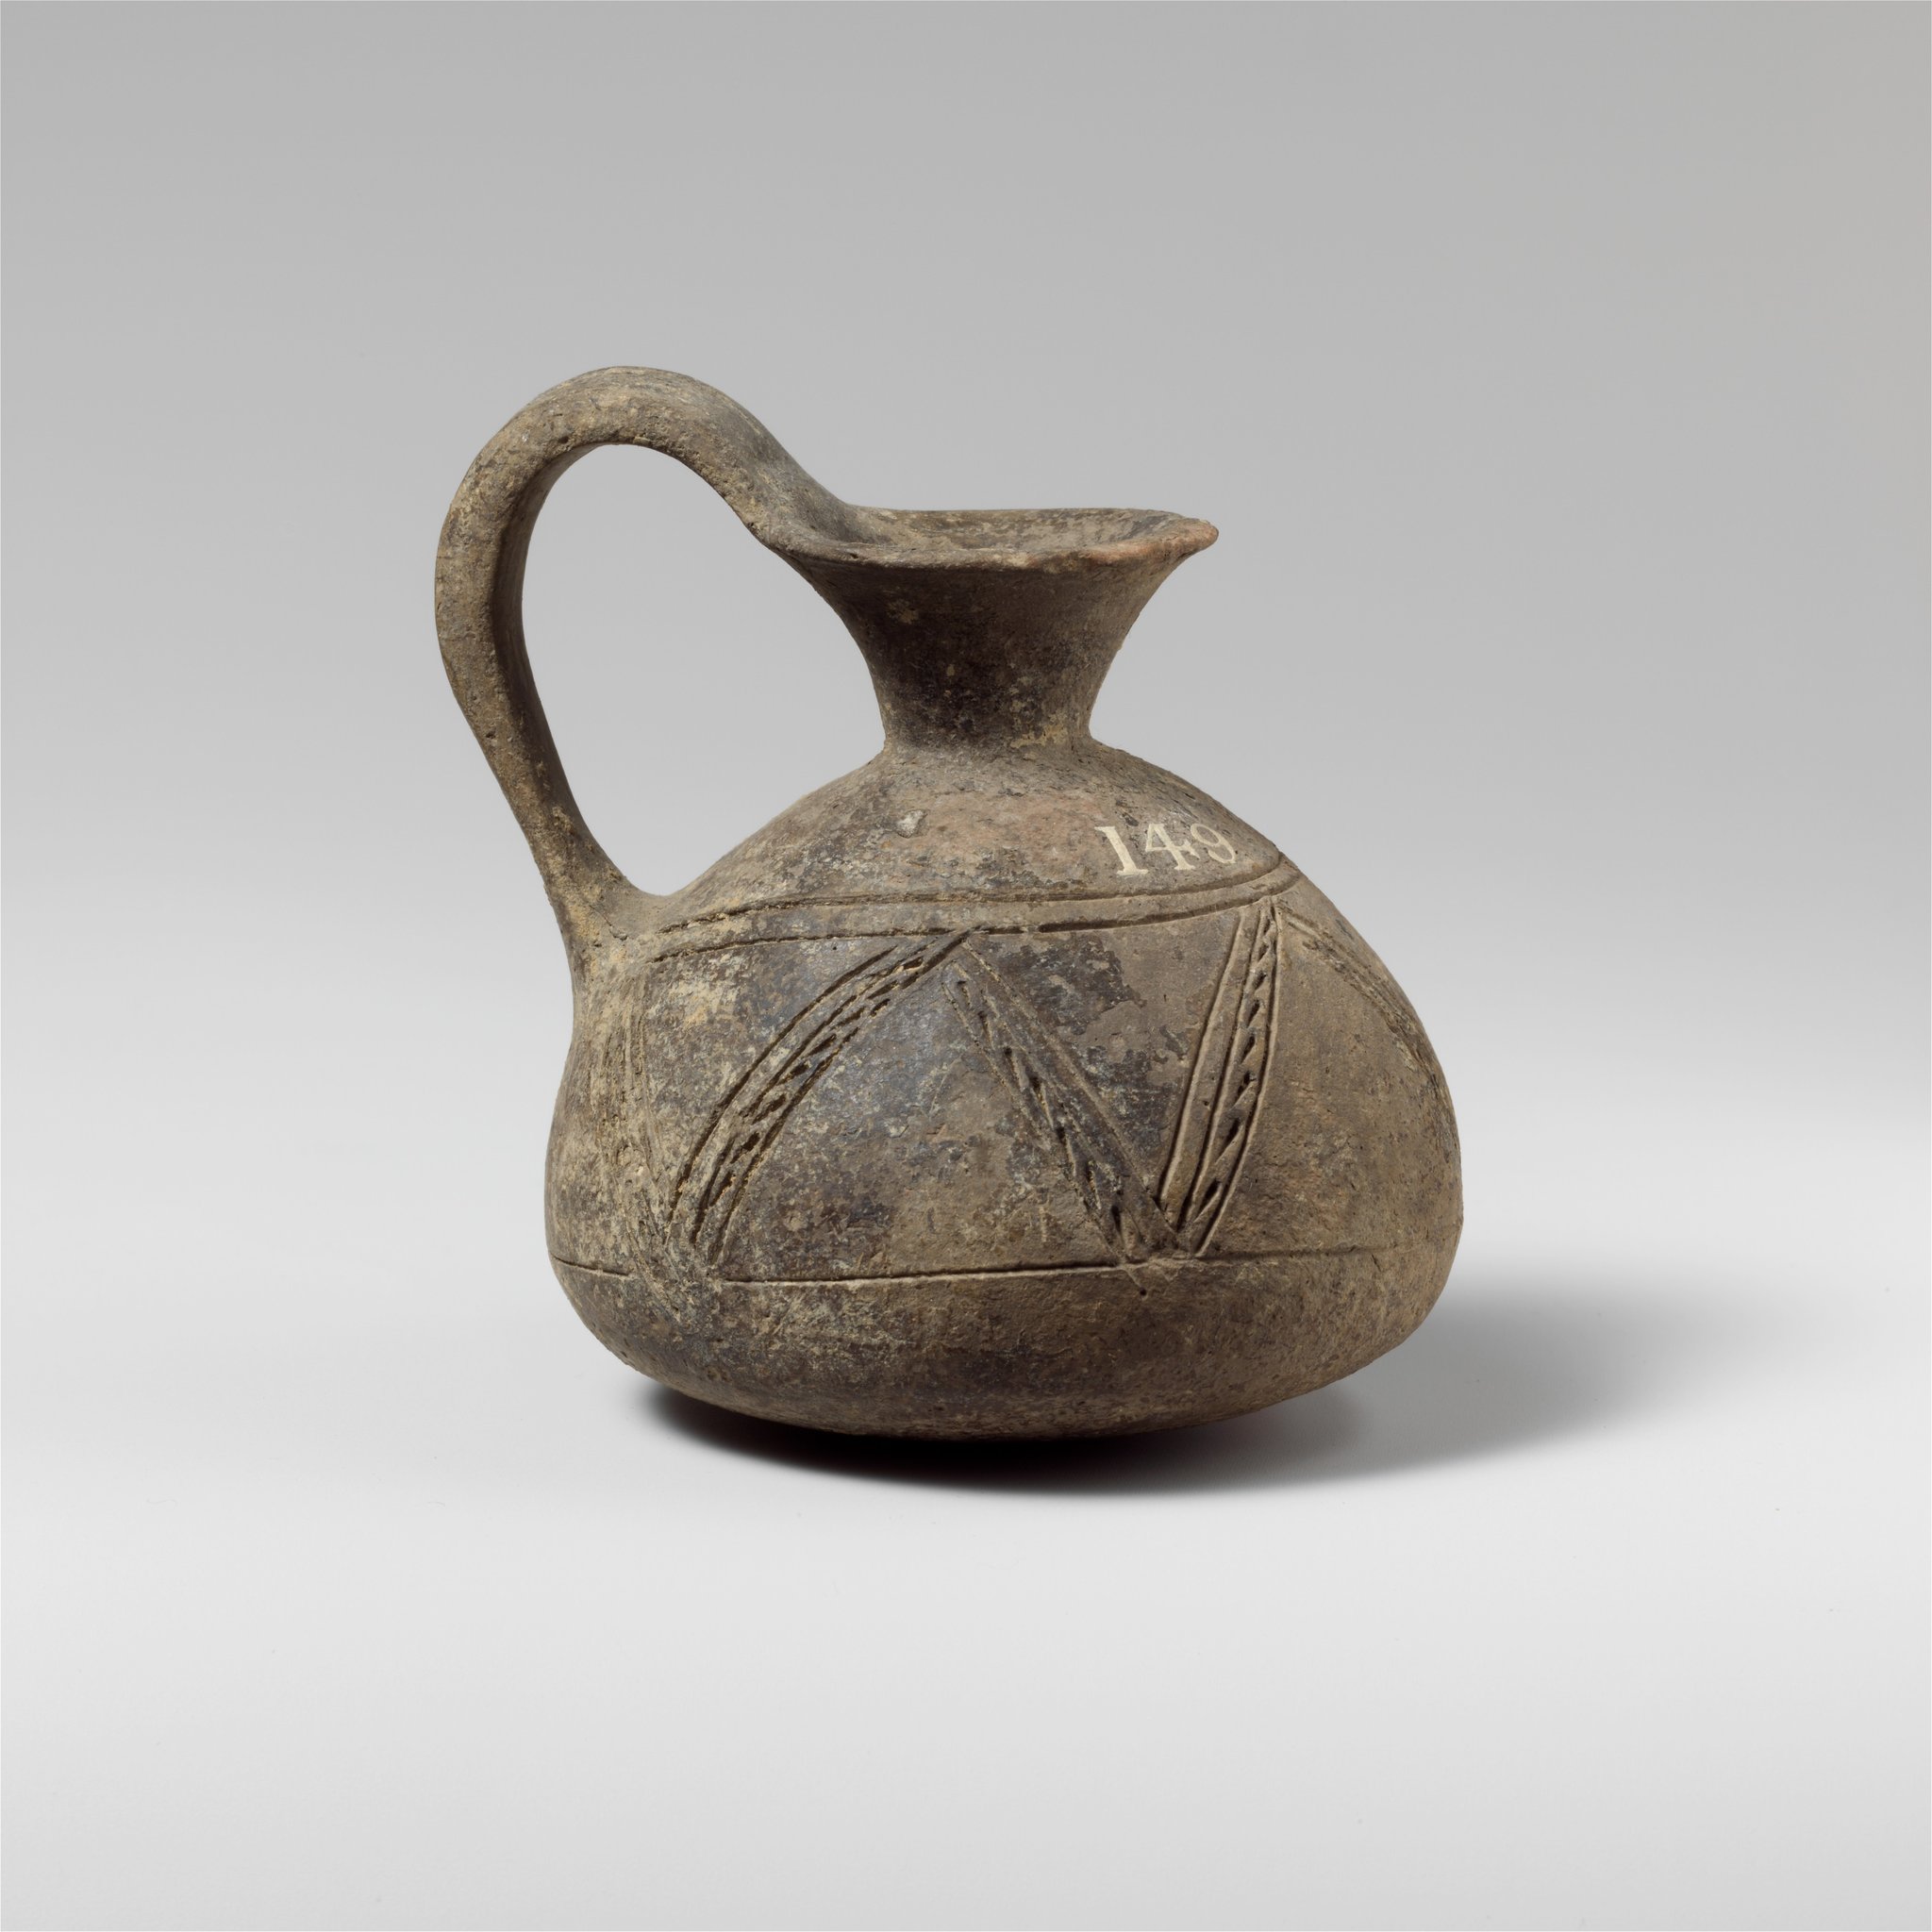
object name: jug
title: Terracotta jug with incised decoration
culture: cypriot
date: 1600-1050 BCE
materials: terracotta